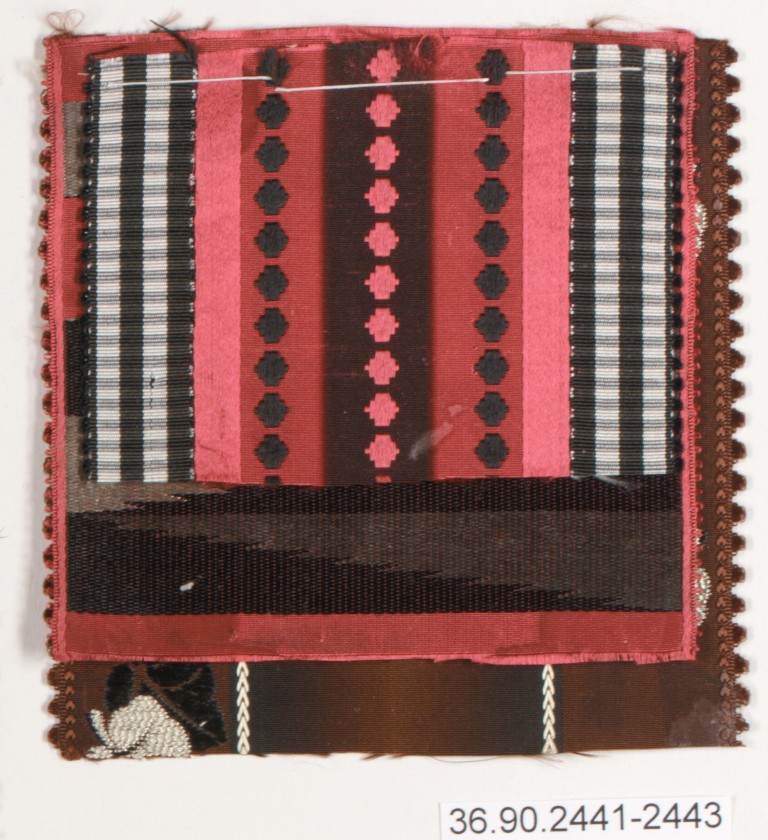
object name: ribbon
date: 1801-1900